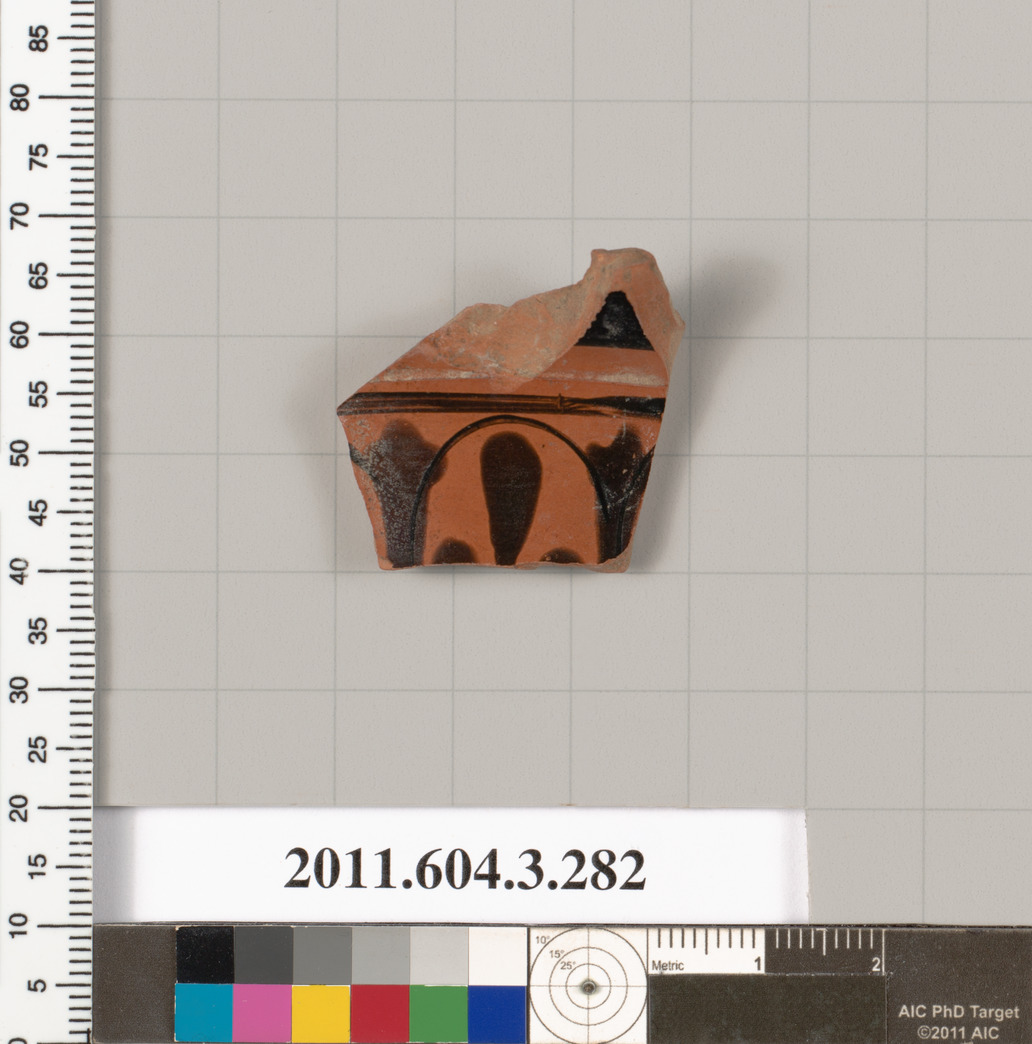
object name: neck amphora fragment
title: Terracotta fragment of a neck-amphora (jar)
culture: greek, attic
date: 520-510 BCE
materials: terracotta